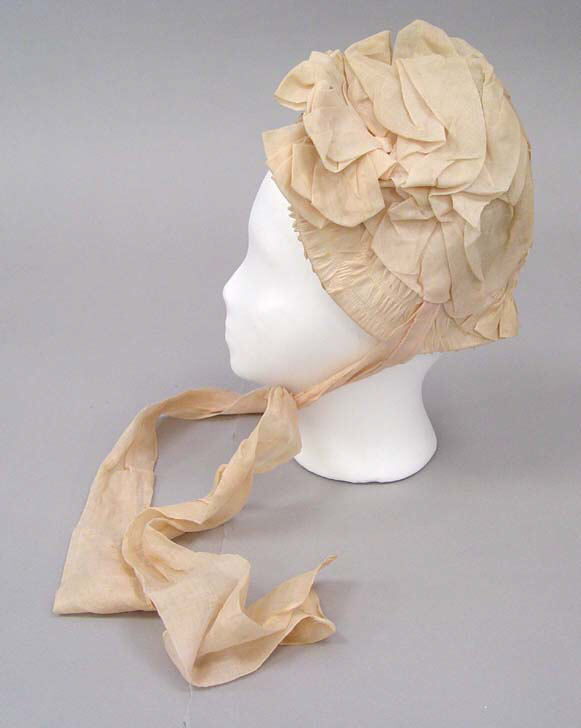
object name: bonnet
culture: american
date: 1880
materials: cotton